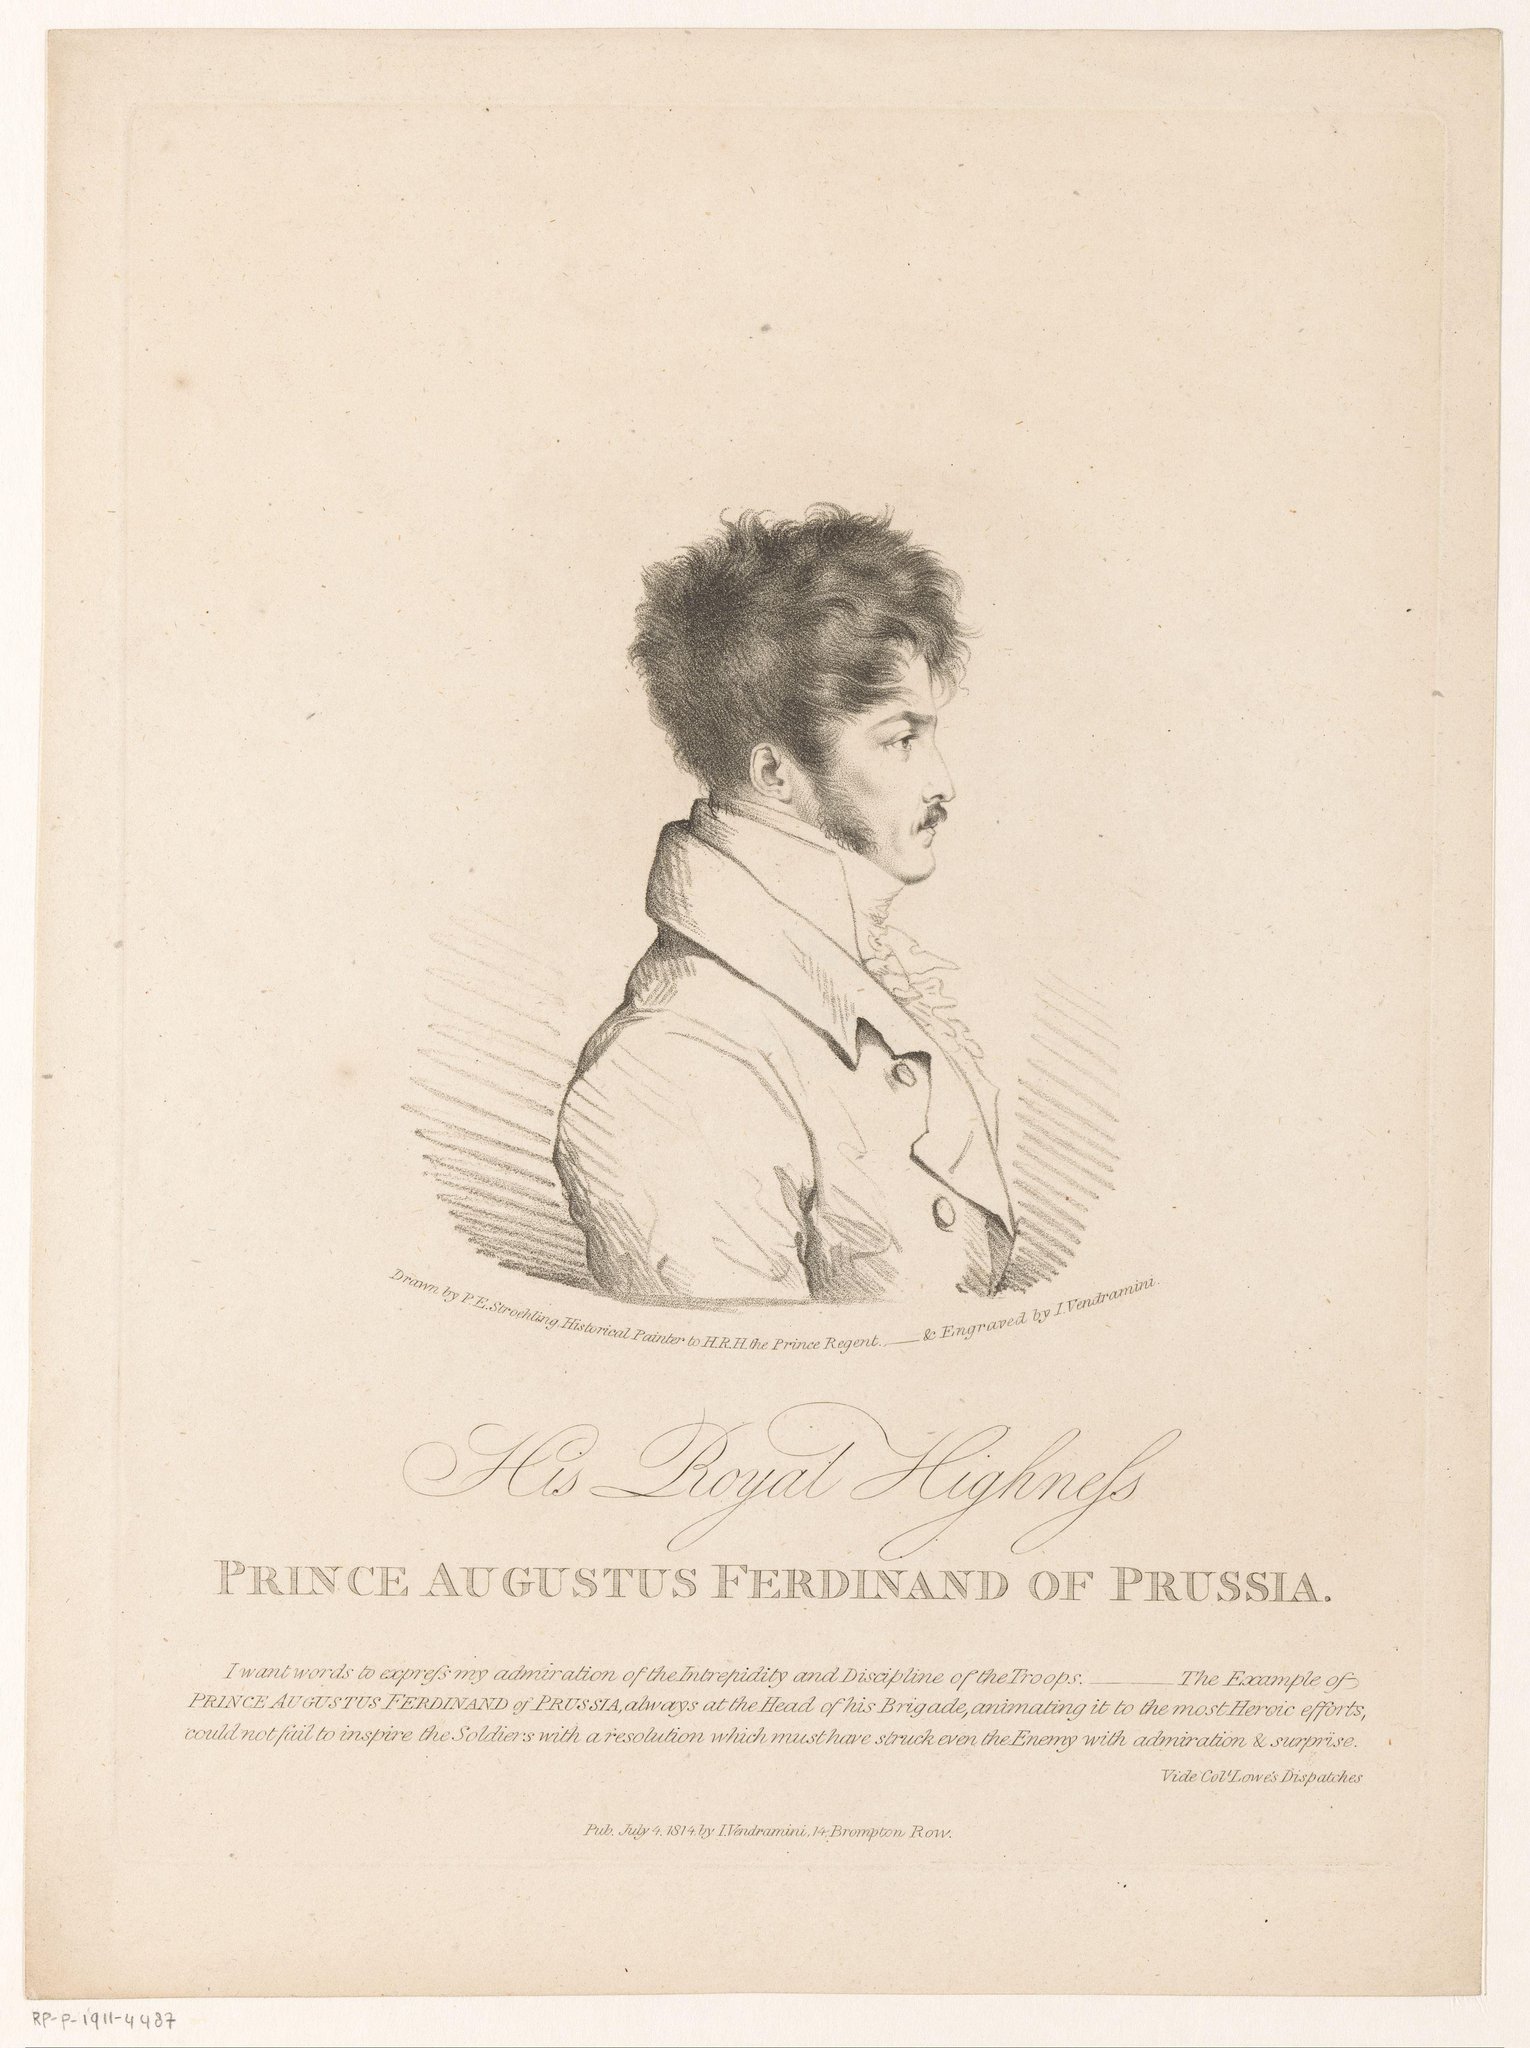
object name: print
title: Portret van Frederik Willem Hendrik August, prins van Pruisen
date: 1814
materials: paper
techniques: engraving, roulette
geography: london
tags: prince, historical persons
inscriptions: collector's mark: Lugt 2228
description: Onder het portret drie regels Engelse tekst.